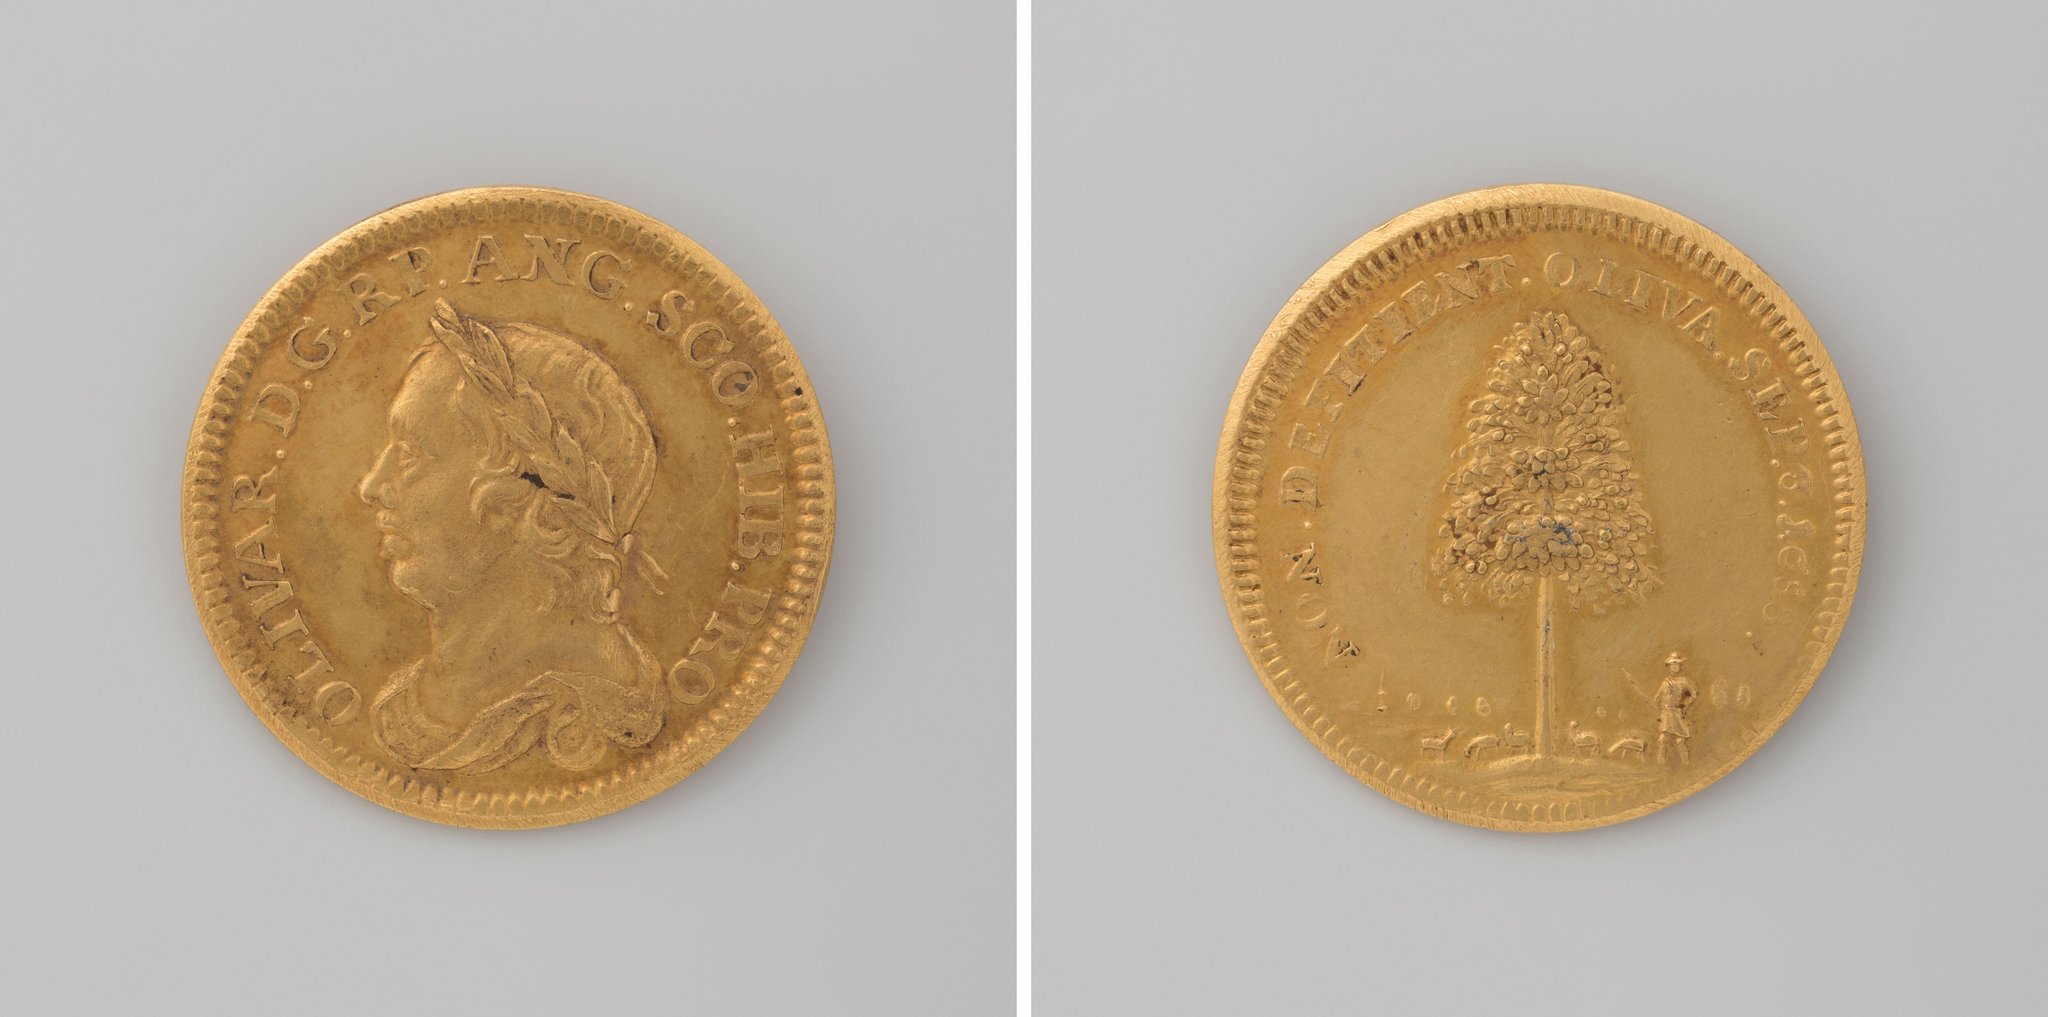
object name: history medal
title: Dood van Cromwell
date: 1658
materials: gold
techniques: striking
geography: england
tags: london, oliver cromwell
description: Gouden penning. Voorzijde: borststuk man met lauwerkrans binnen omschrift. Keerzijde: schaapherder met kudde onder olijfboom binnen omschrift